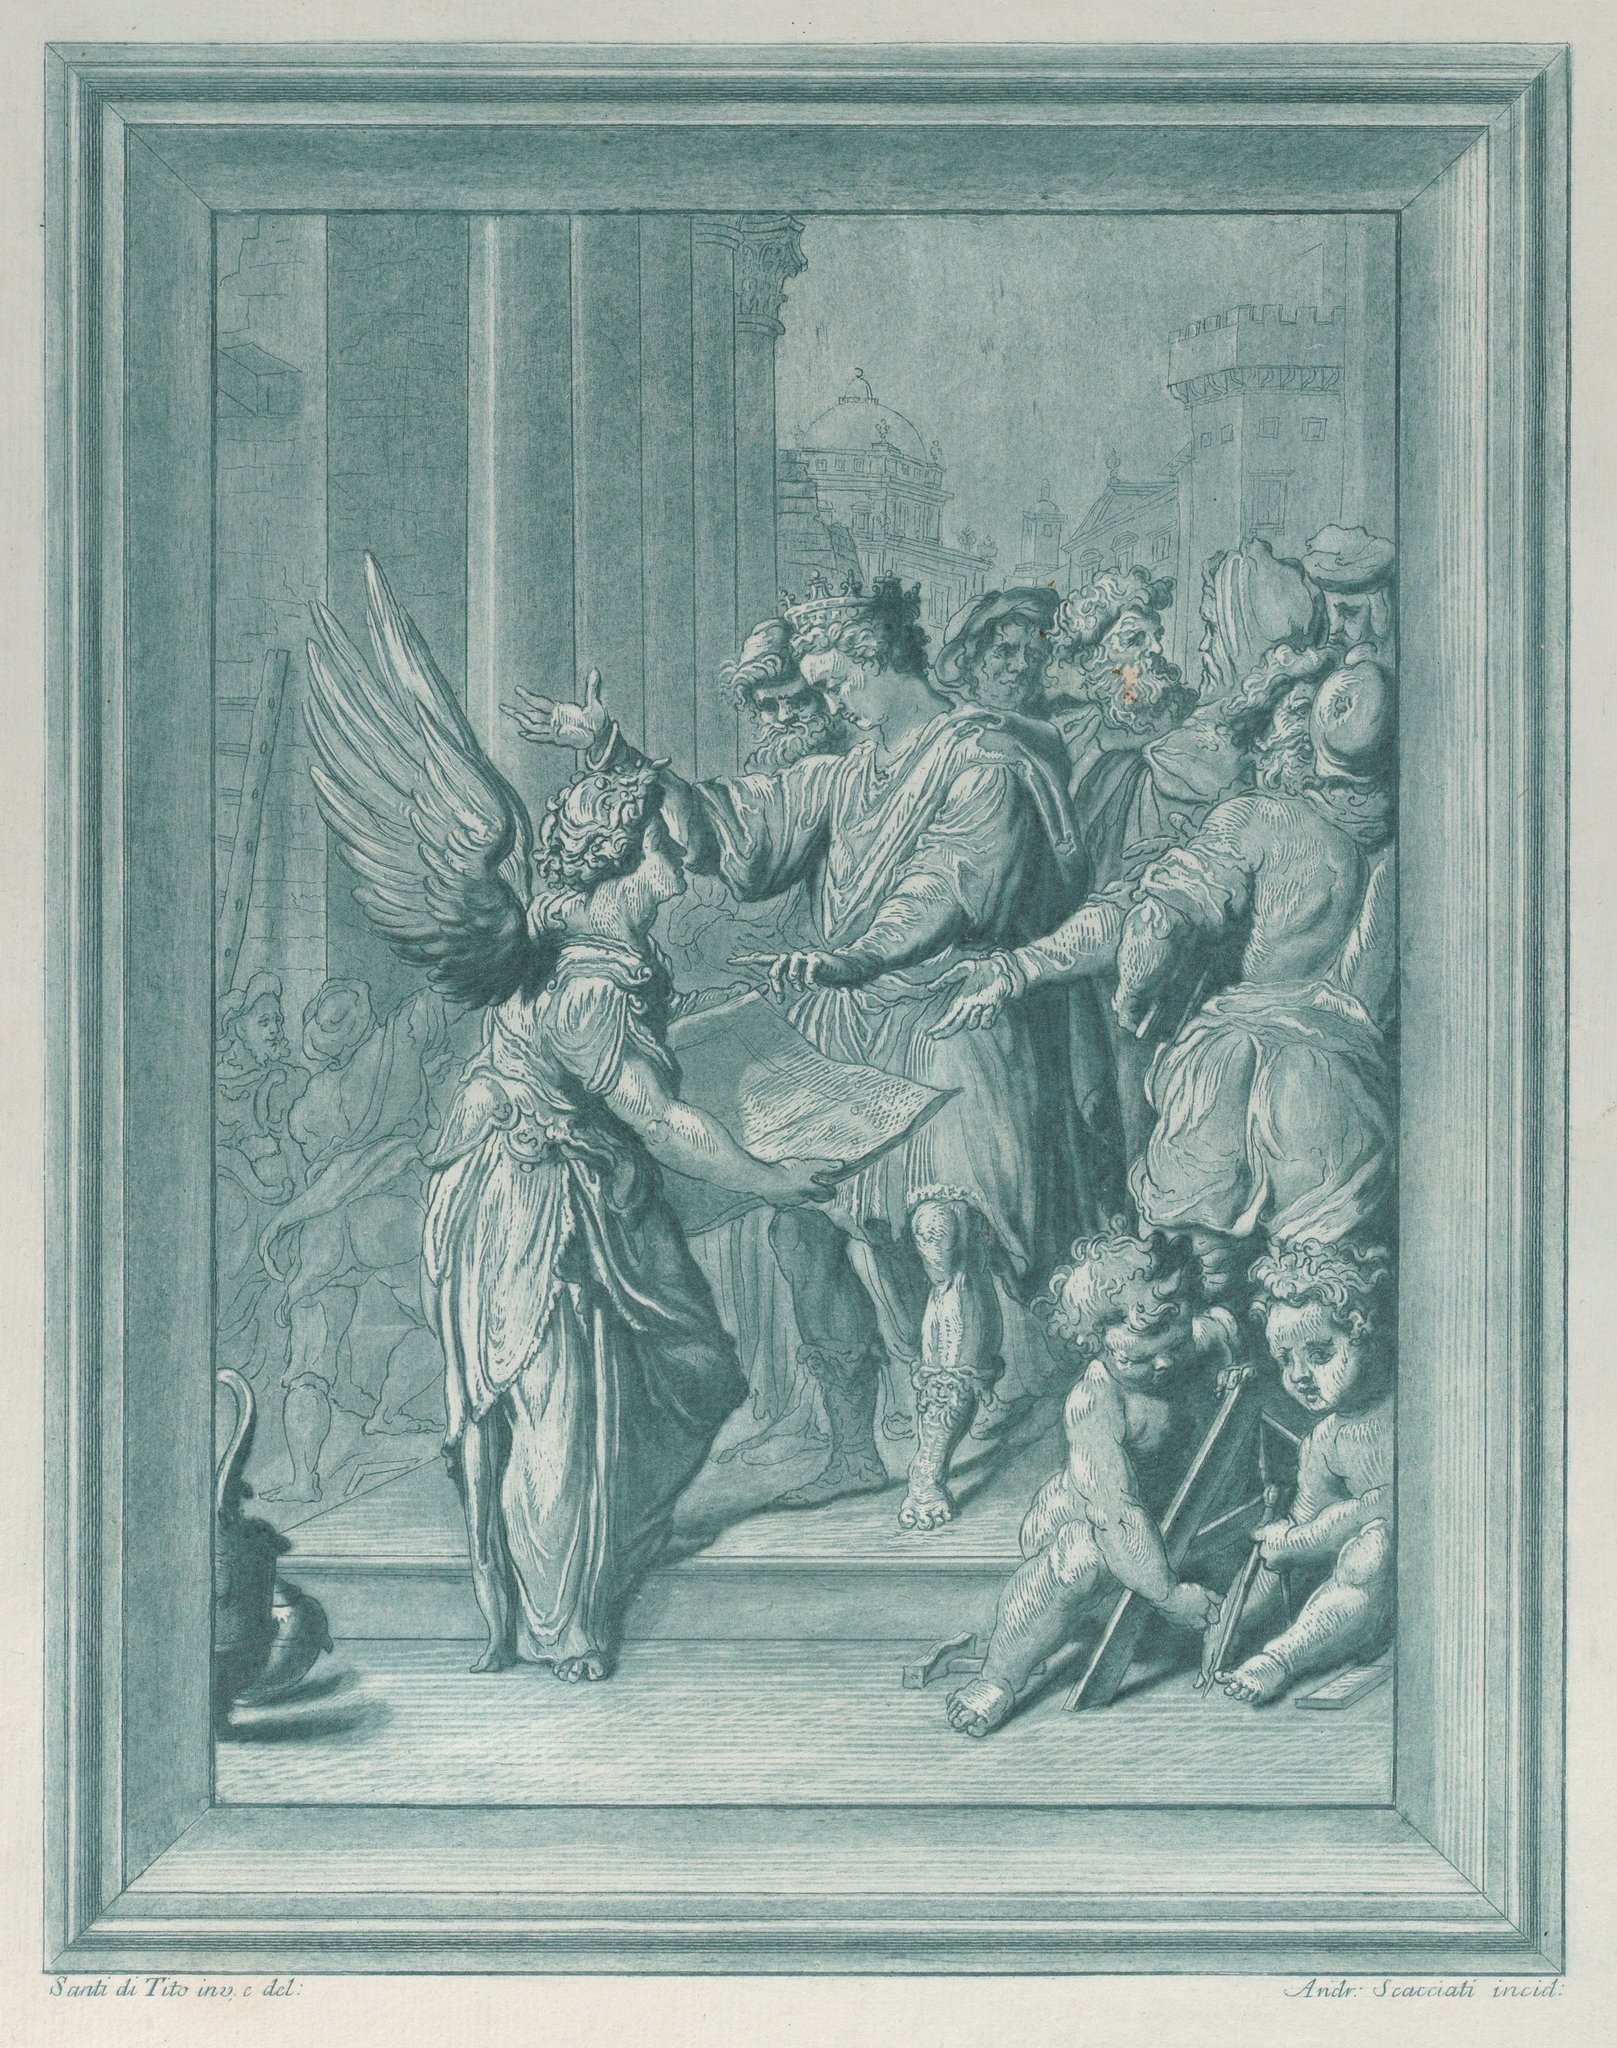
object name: print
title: An angel directing the construction of a building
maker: andrea scacciati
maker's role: artist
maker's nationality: italian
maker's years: 1725-1771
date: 1750-1770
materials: ink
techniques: aquatint, etching